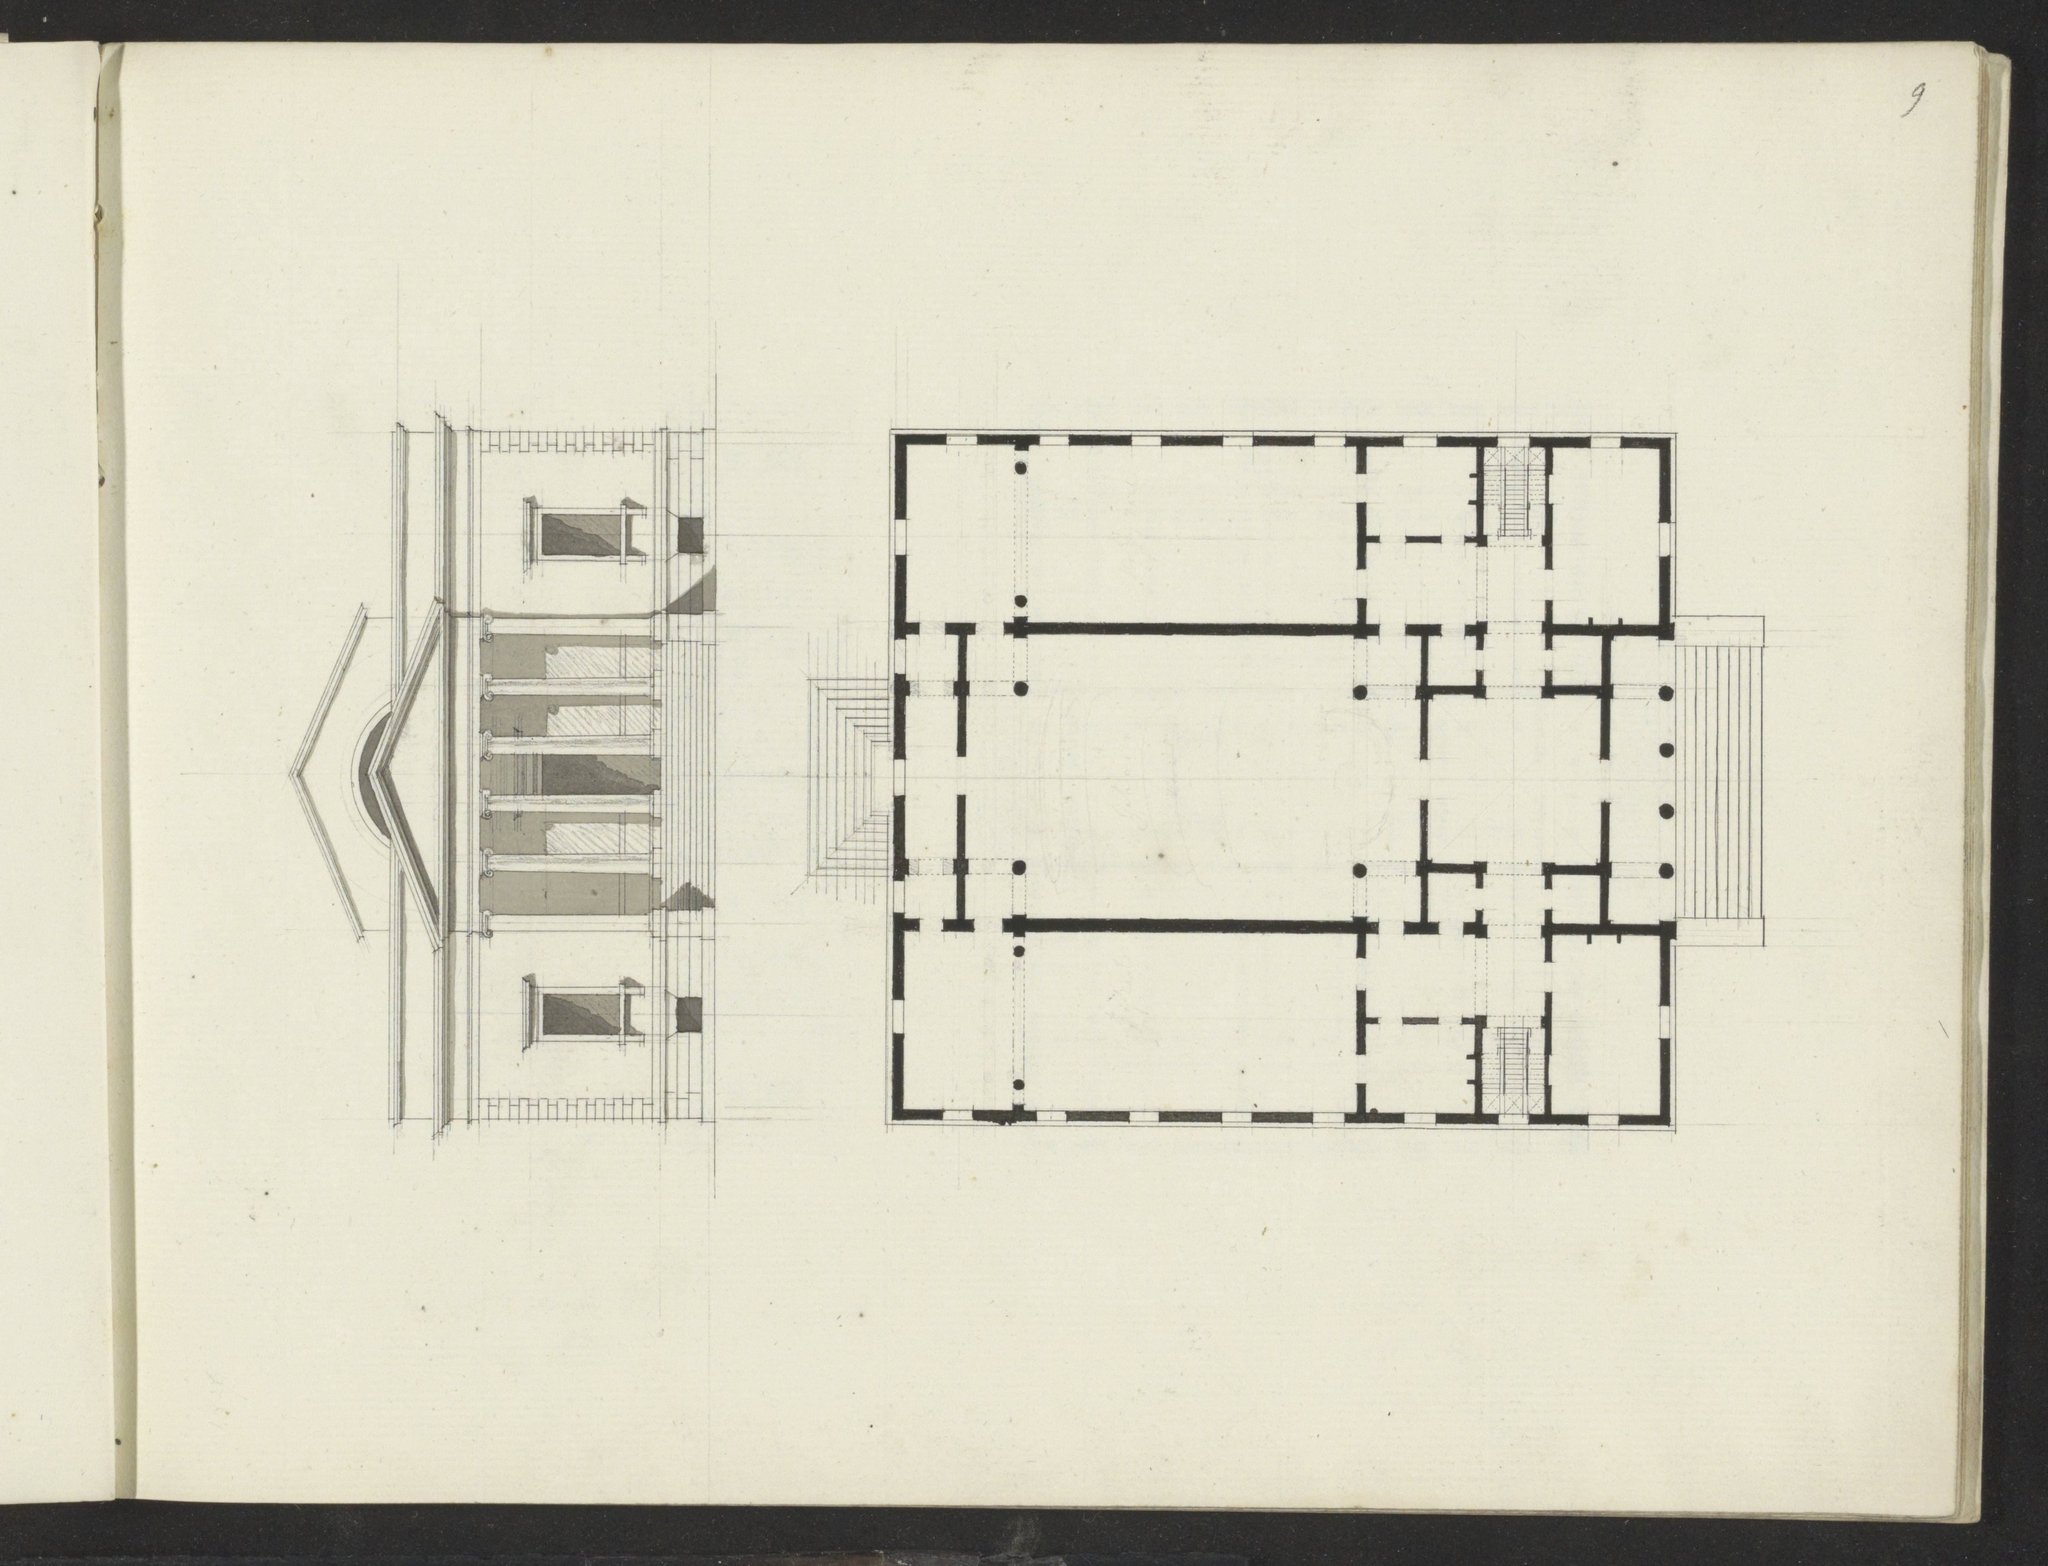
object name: sketchbook leaf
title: Plattegrond en opstand van de voorgevel van een gebouw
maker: willem springer jr.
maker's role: draughtsman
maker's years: 1815-1907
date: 1825-1907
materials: ink, paper, pencil, watercolor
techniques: brush, pen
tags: façade (of house or building), plan ~ architecture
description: Pagina 9 uit een schetsboek met 28 pagina's.